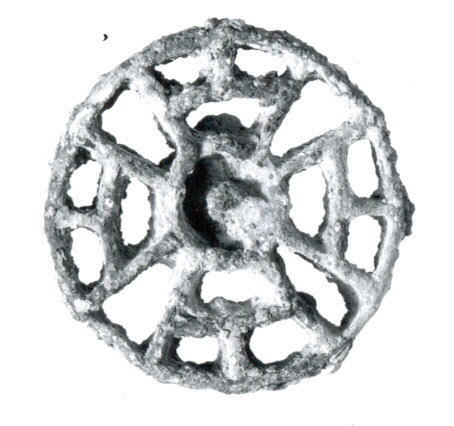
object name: stamp seal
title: Compartmented stamp seal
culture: bactria-margiana archaeological complex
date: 2333-1668 BCE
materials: copper alloy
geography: bactria-margiana